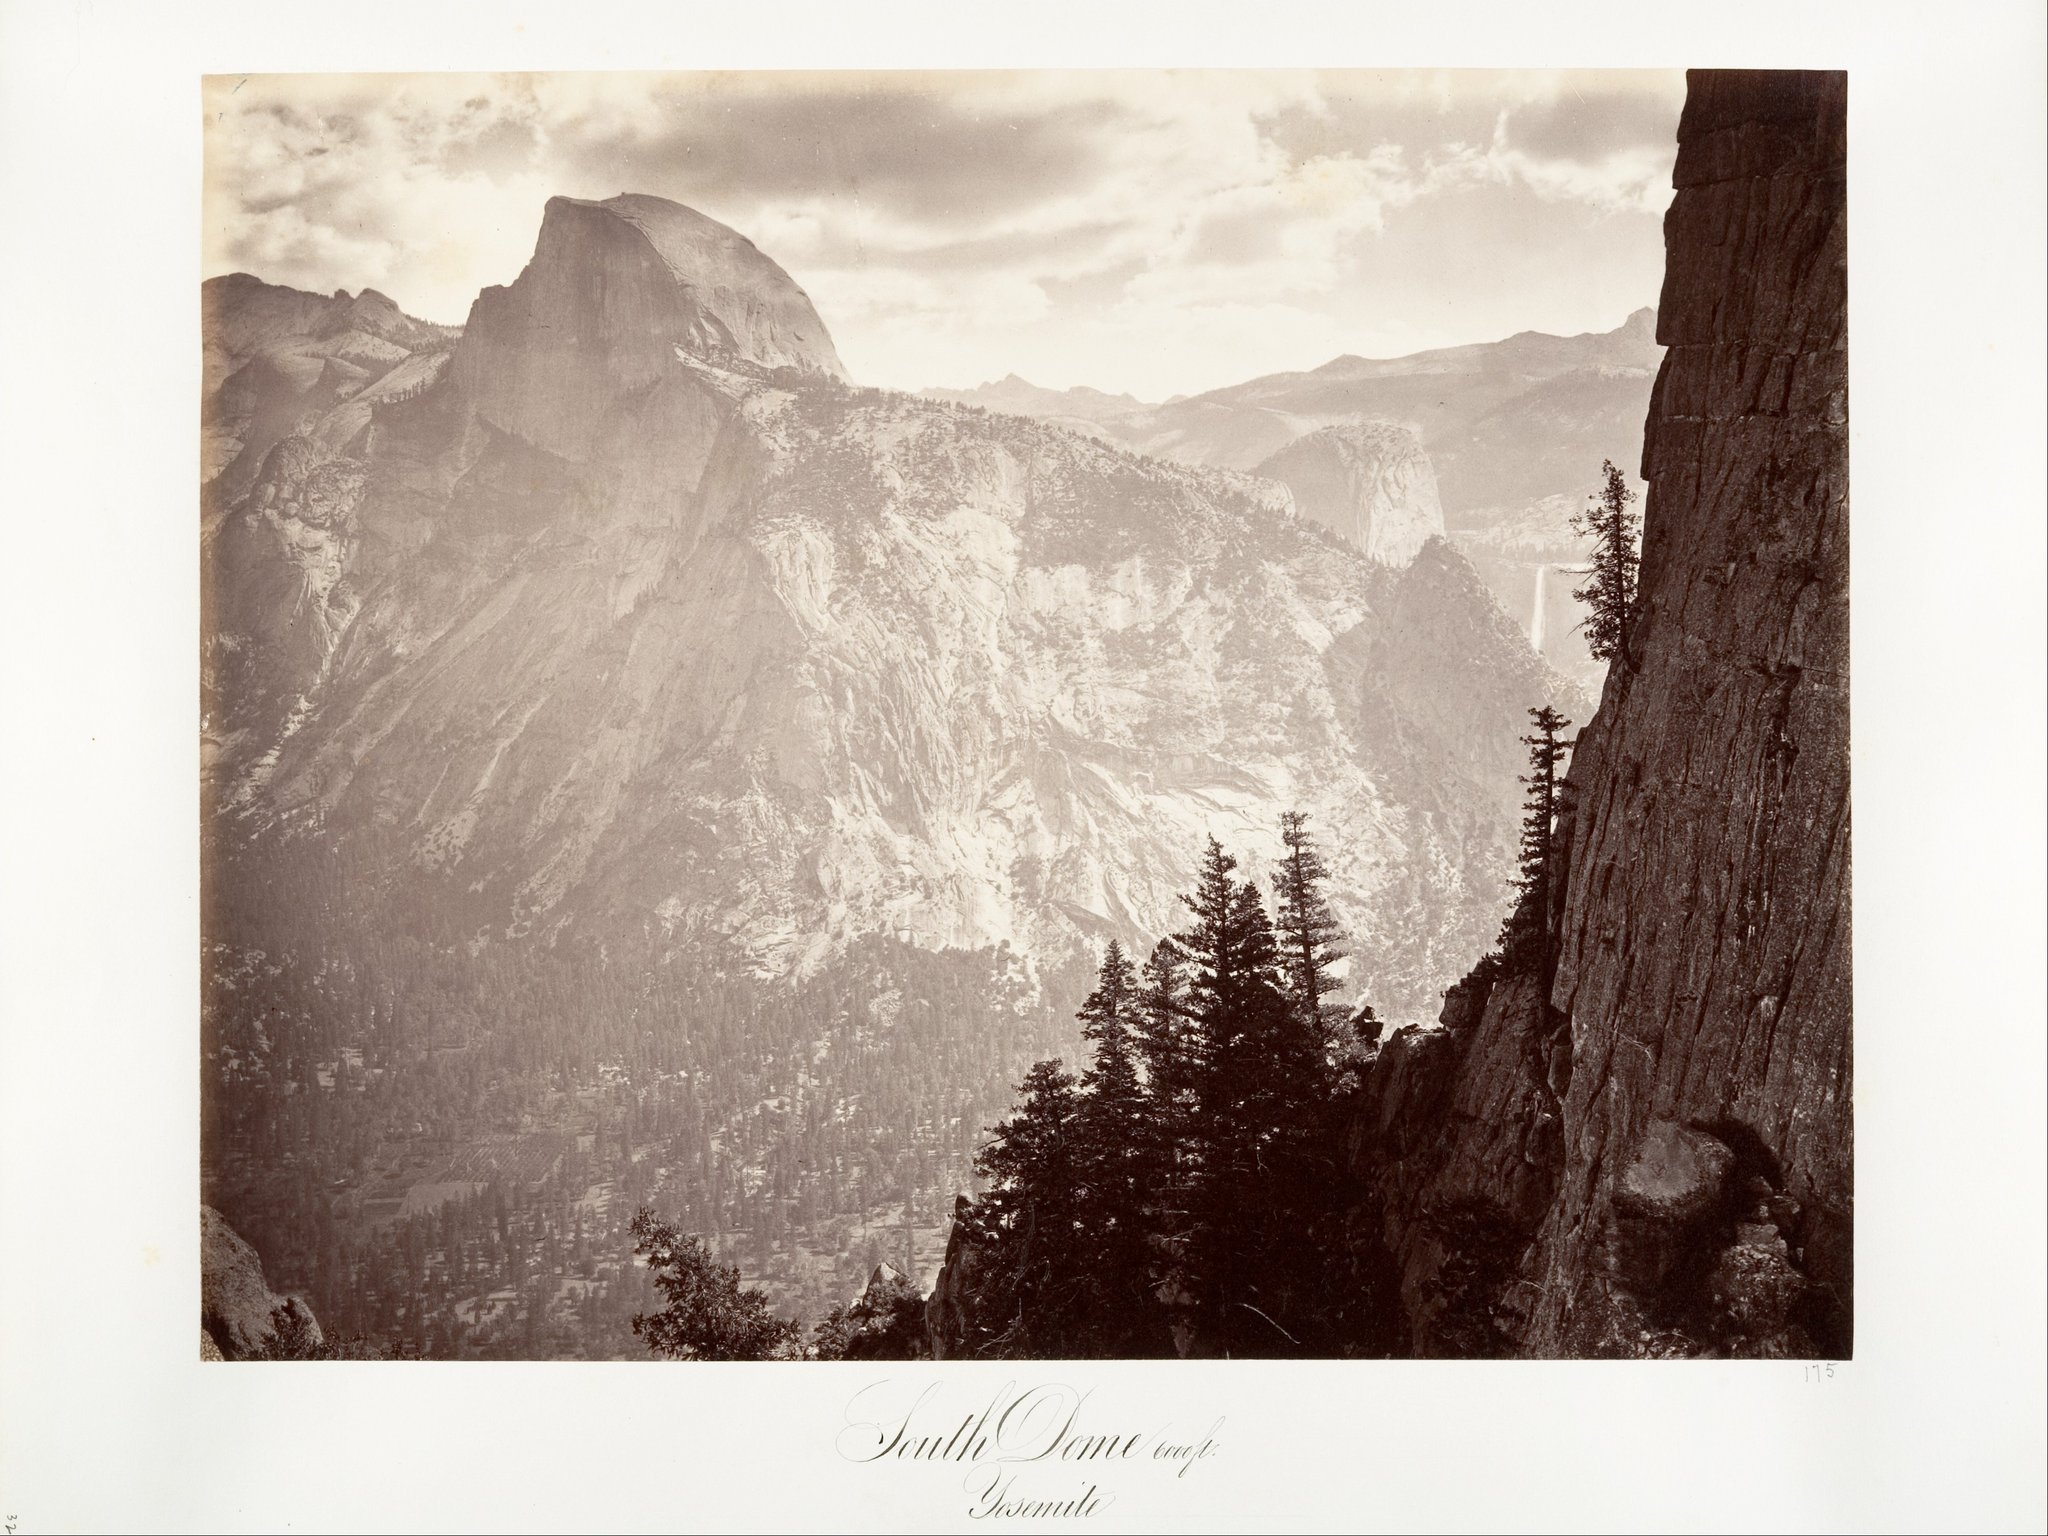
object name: photograph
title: South Dome, 6,000 feet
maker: carleton e. watkins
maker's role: artist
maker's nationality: american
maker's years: 1829-1916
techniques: albumen silver print, glass negative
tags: mountains,landscapes